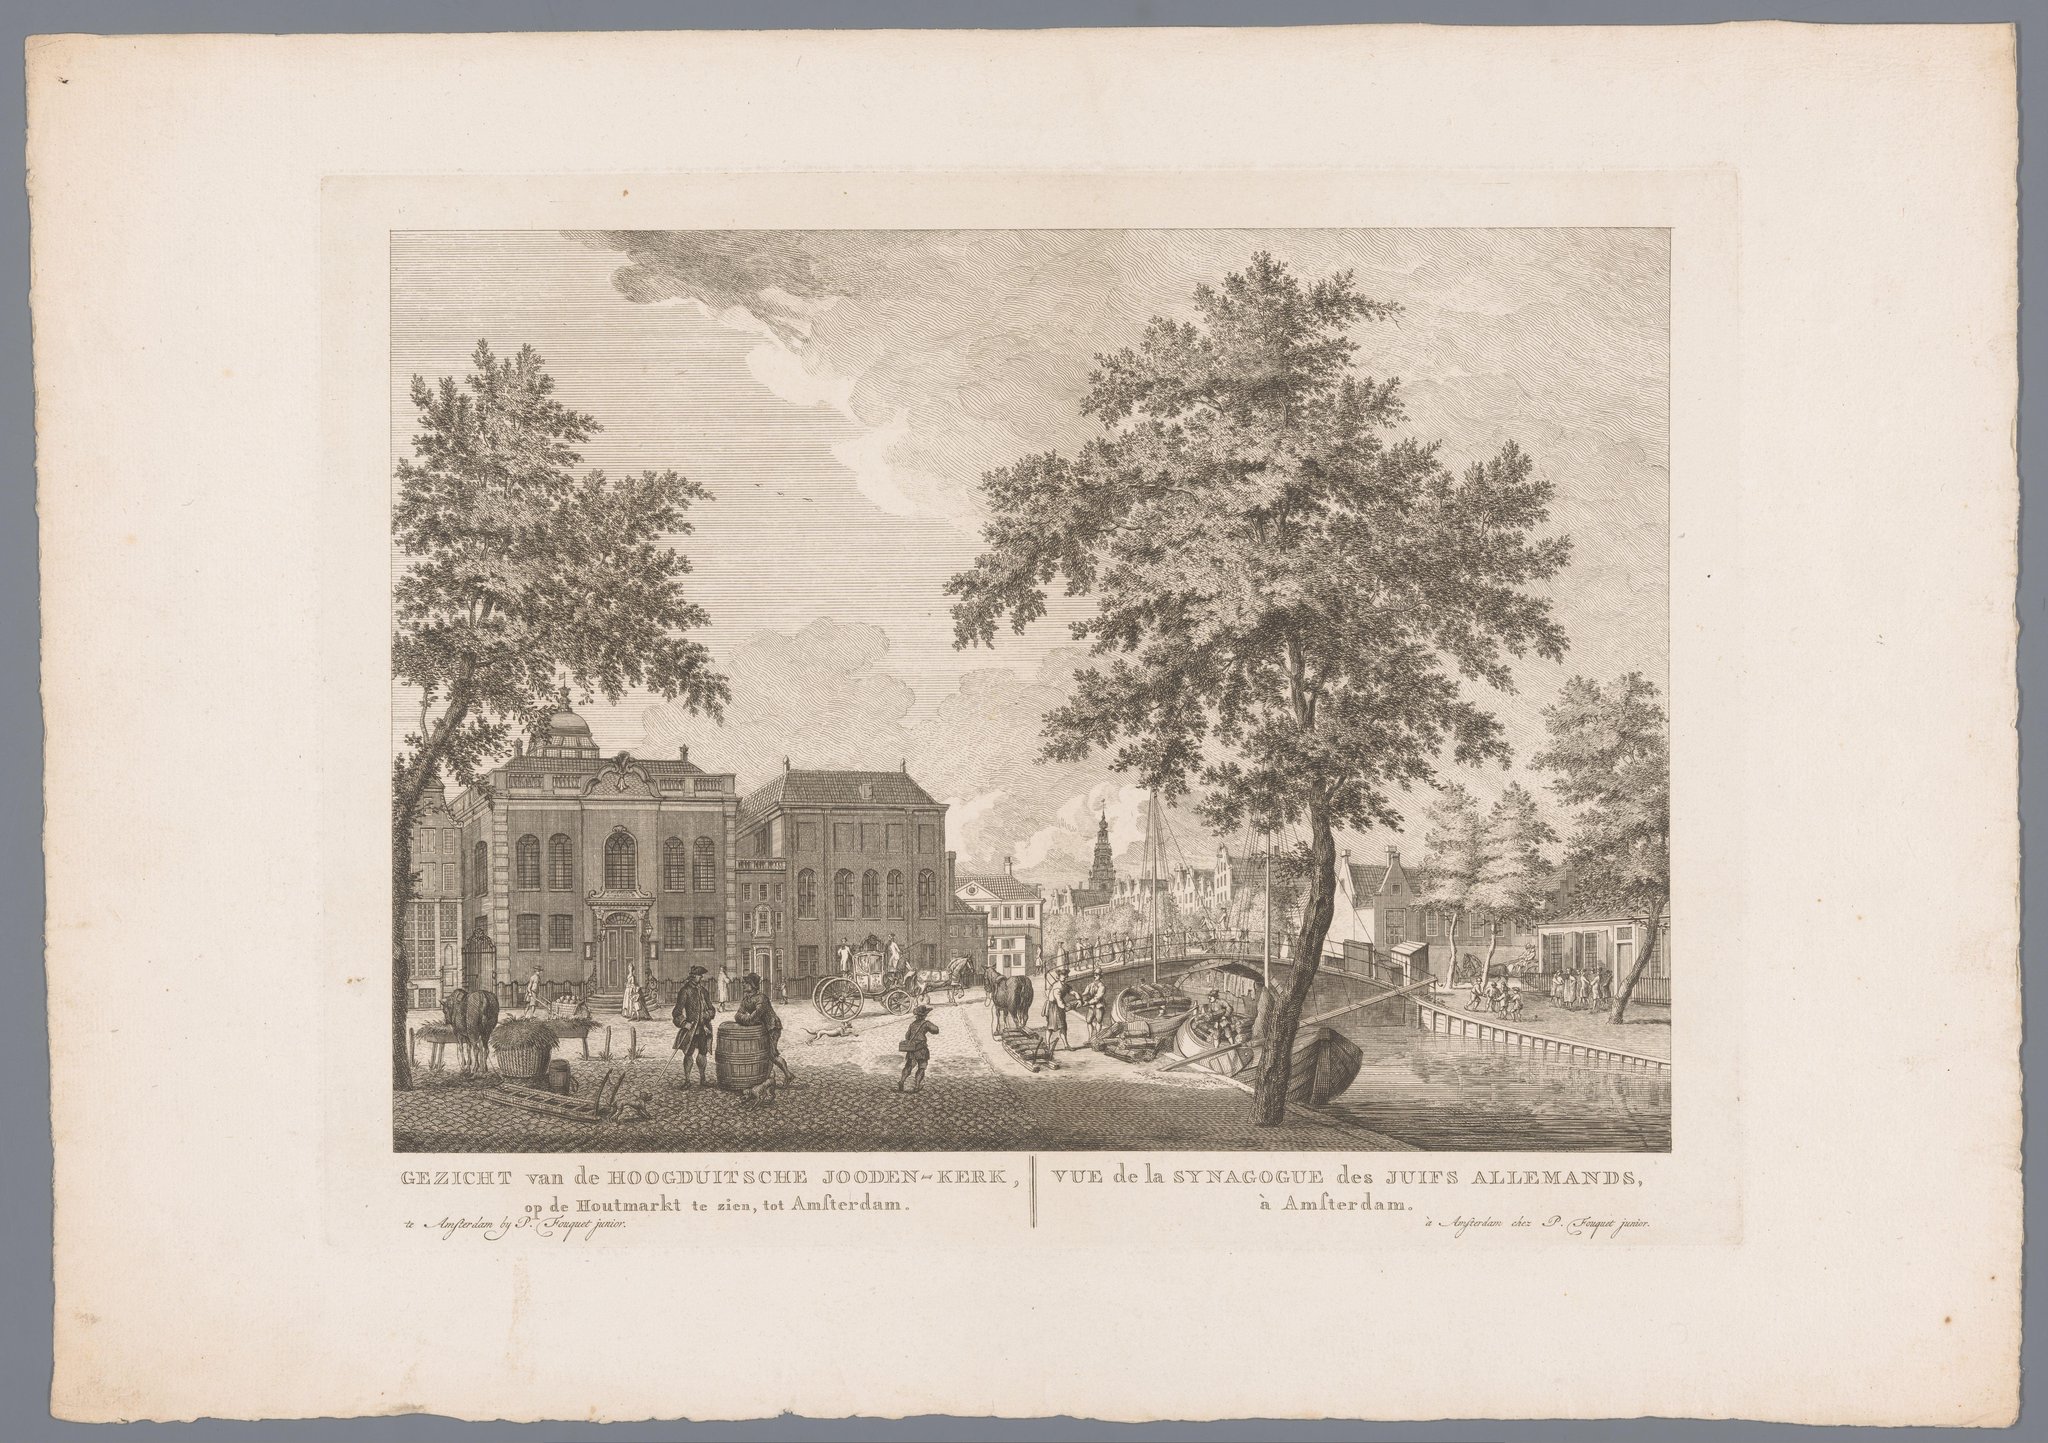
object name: print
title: Atlas van Fouquet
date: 1768-1783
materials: paper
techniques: etching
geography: amsterdam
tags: bridge in city across river, canal, etc. (+ city(-scape) with figures, staffage), 'ashkenazim' ~ jewish communities, the synagogue (as building and place of worship ~ jewish religion), canals, waters (in city) (+ city(-scape) with figures, staffage), street (+ city(-scape) with figures, staffage)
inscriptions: collector's mark: Lugt 2233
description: Vanaf 1760 gaf Pierre Fouquet stadsgezichten van Amsterdam naar tekeningen van verschillende kunstenaars uit. Deze prenten werden aanvankelijk los verkocht. Later werden ze samengebonden verkocht in verschillende volgordes en aantallen in: (1). Afbeeldingen van de wyd-vermaarde koopstad Amsterdam benevens des zelvs voornaamste gebouwen en gezigten alle naar het leeven getekend / Receuil des edifices les plus considerables et des plus belles vues, de la fameuse ville d'Amsterdam, dessinées d'après nature. Amsterdam: Pierre Fouquet, 1778-1783. Deze 'uitgave' bestond waarschijnlijk alleen uit een titelblad en inhoudsopgave van de tot dusver 100 uitgegeven prenten, die de koper zelf aan zijn of haar reeds verzamelde prenten kon toevoegen. De hoeveelheid en volgorde van prenten verzameld onder deze titel verschilt dus sterk. (2). Nieuwe atlas, van de voornaamste gebouwen en gezigten der stad Amsterdam, met derzelver beknopte beschryvingen. 2 dln. Amsterdam: Daniël Jean Changuion en Petrus den Hengst [in opdracht van Pierre Fouquet], 1783. Ook werden er door verschillende uitgevers tussen 1788 (Amsterdam: Petrus Conradi) en 1805 (Amsterdam: Evert Maaskamp) heruitgaven gepubliceerd.